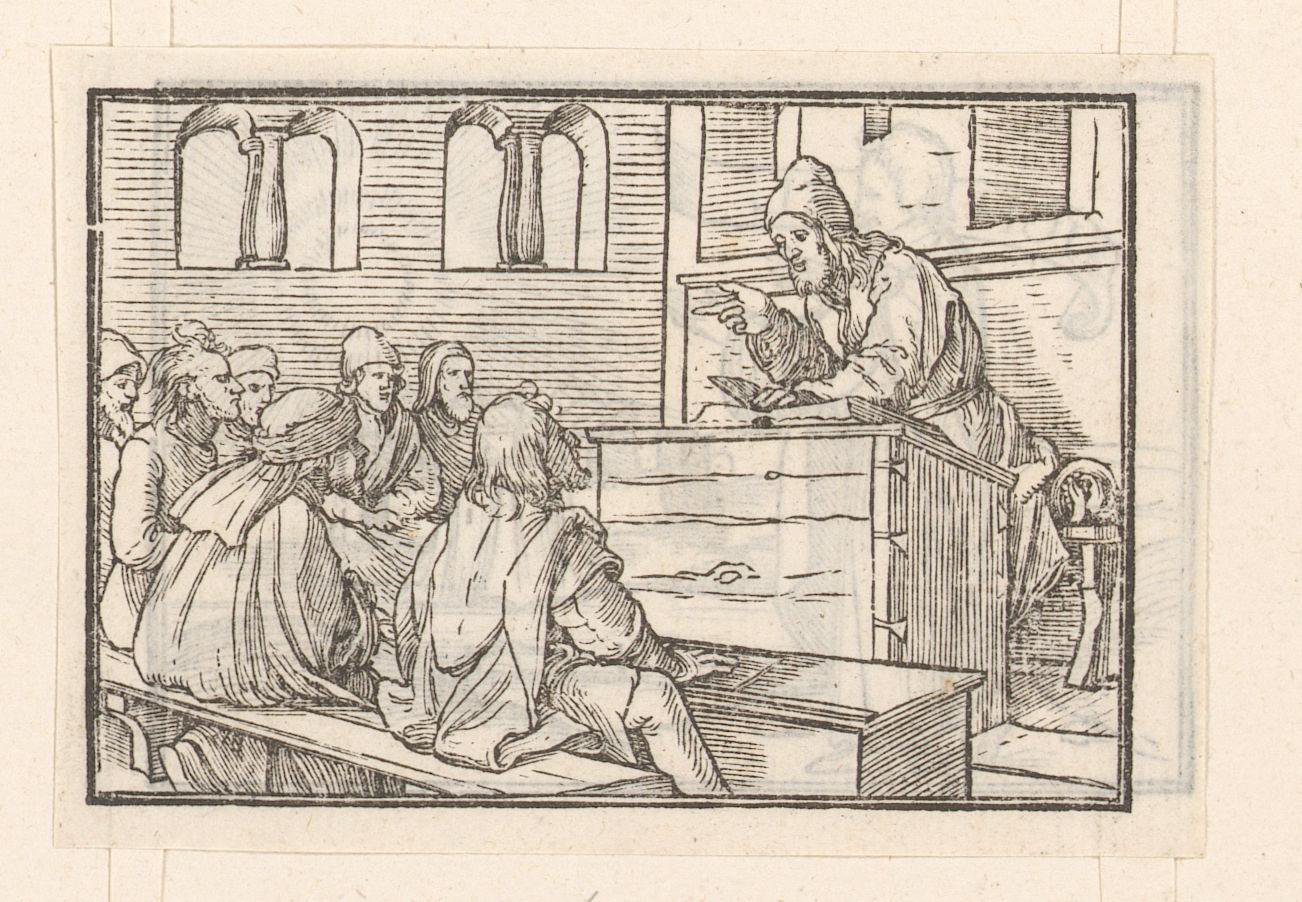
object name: print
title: Profeet Amos onderwijst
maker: veit rudolf specklin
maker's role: print maker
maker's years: -1550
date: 1538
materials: paper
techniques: woodcut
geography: switzerland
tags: amos, the herdsman of tekoa, prophesies at bethel (amos 1-2)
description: Boekillustratie voor het eerst gebruikt in: Biblia Utriusque Testamenti iuxta Vulgatam Translationem, Lyon, M. en G. Trechsel (voor Hugo à Porta) 1538. Later in verschillende uitgaven opnieuw gebruikt. Deze prent vermoedelijk gebruikt in één van de uitgaven uitgegeven en/of gedrukt door Jean Frellon, Lyon.